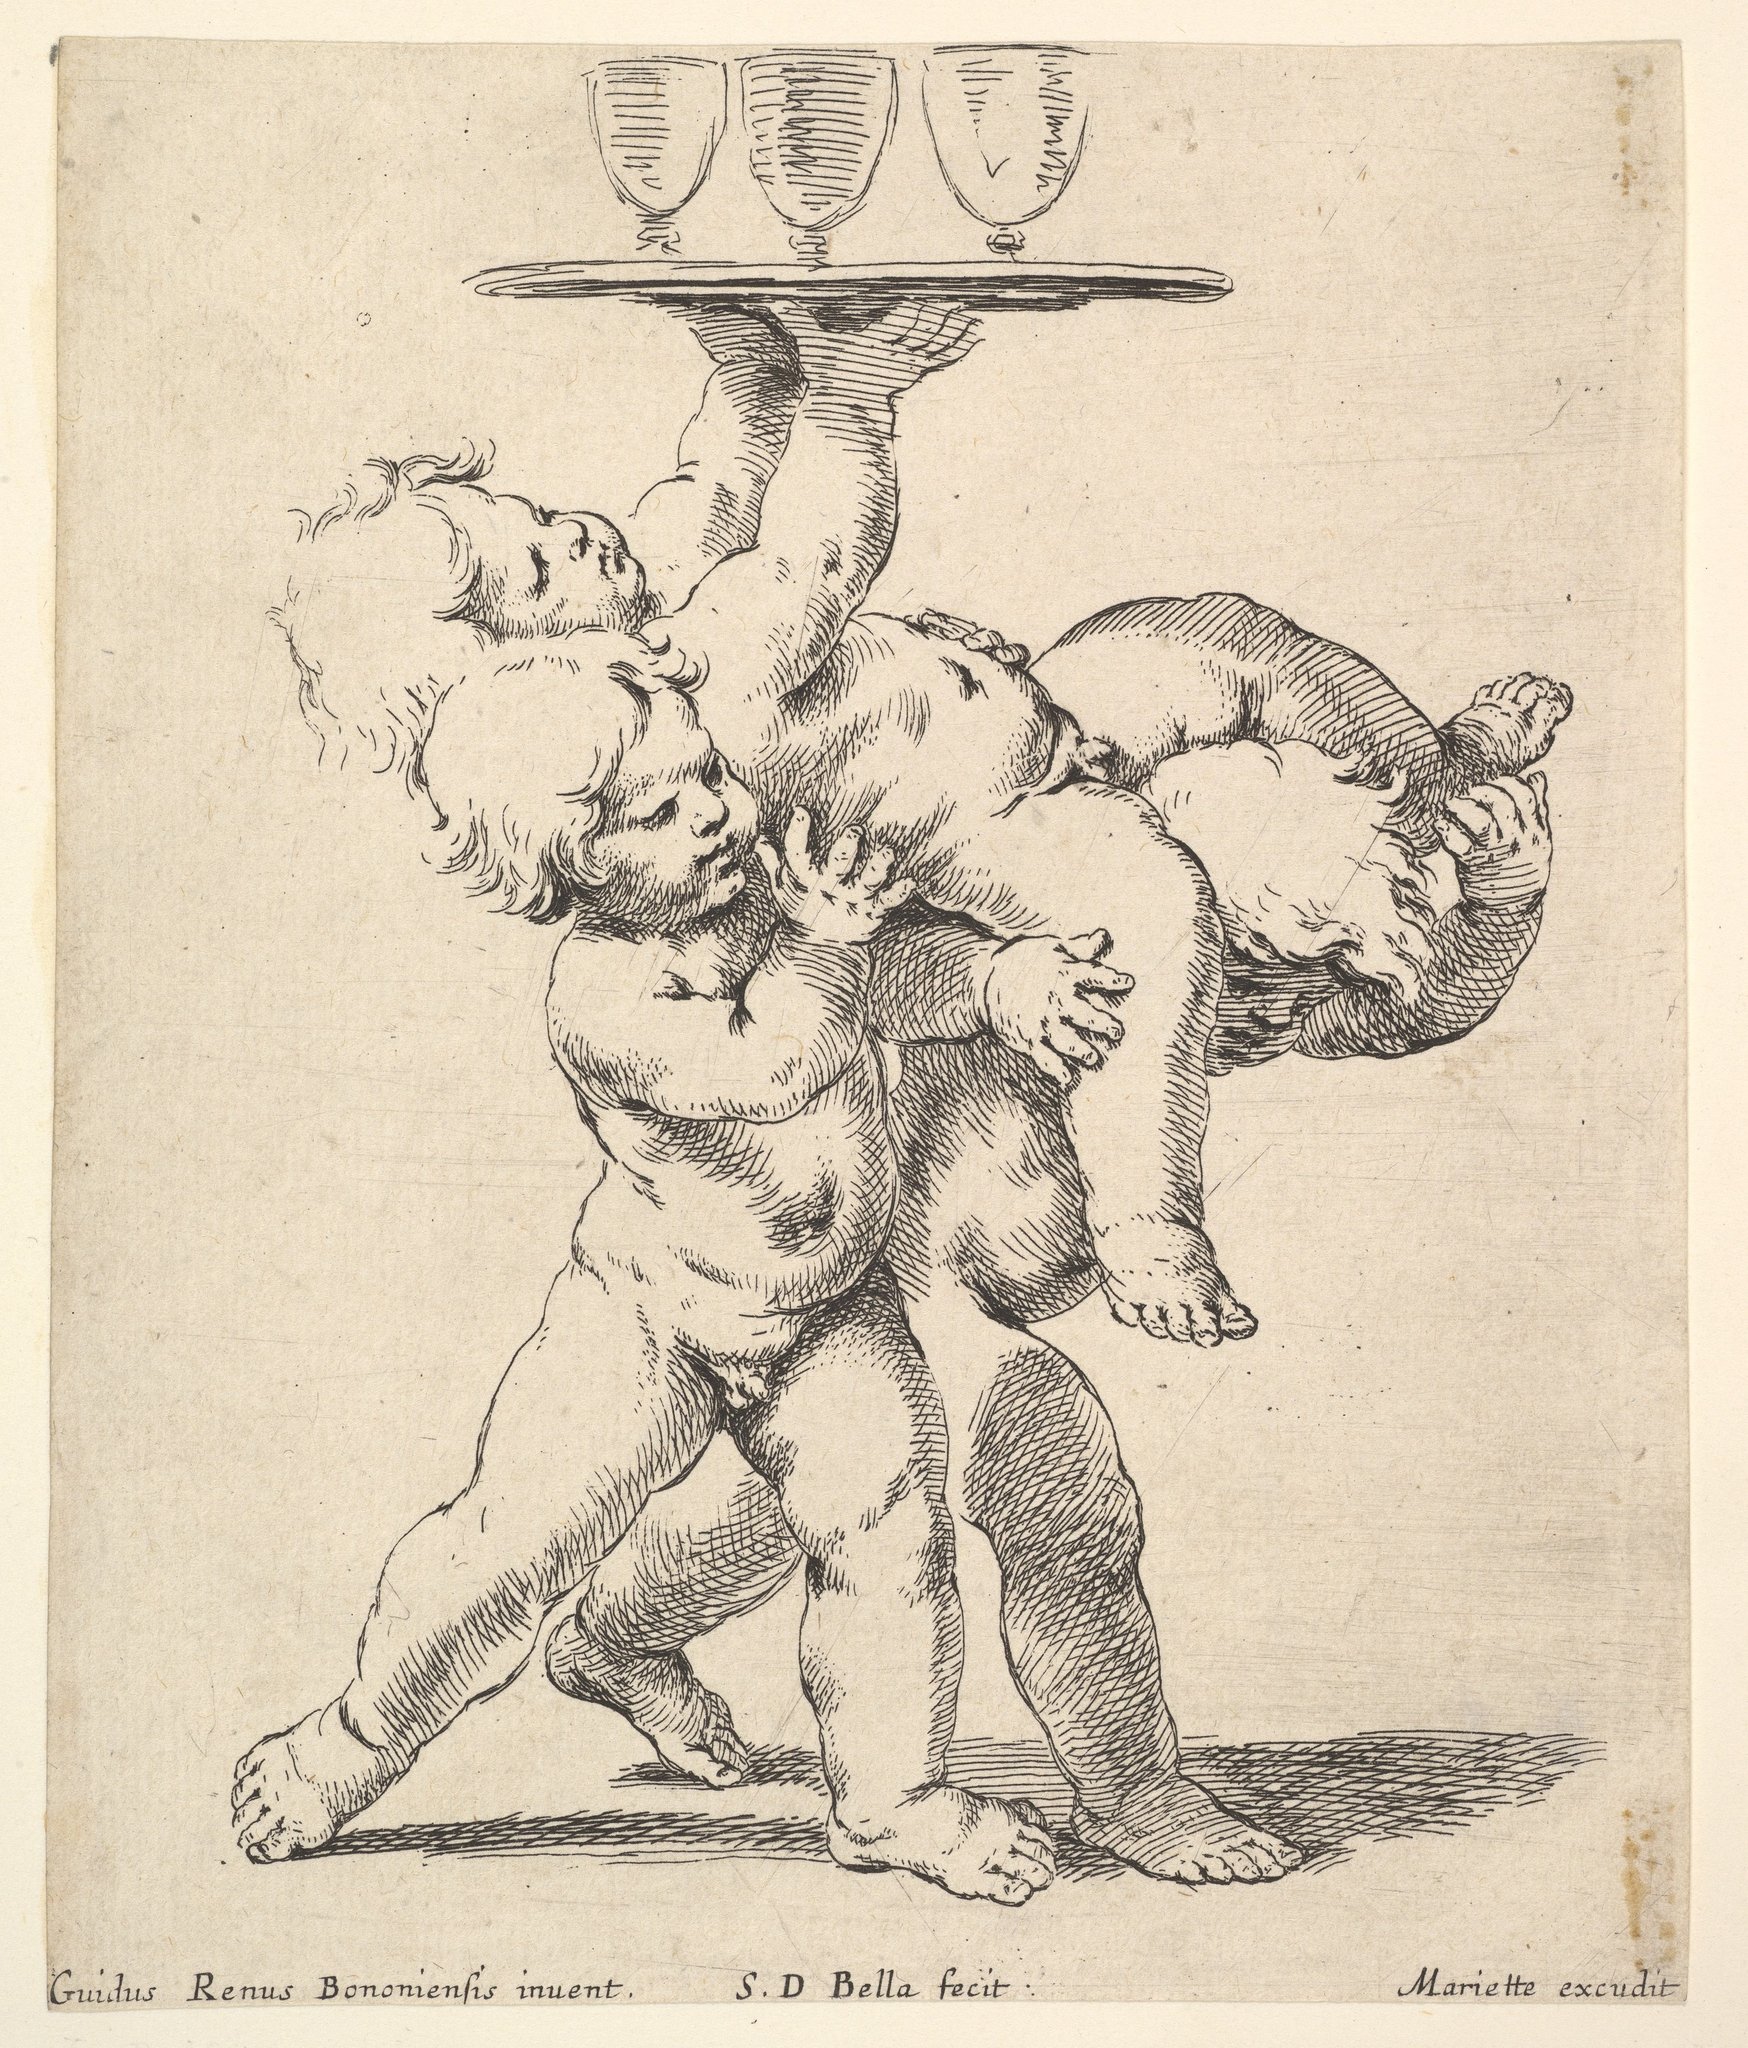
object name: print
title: Three children carrying a tray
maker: stefano della bella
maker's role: artist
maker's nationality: italian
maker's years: 1610-1664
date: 1638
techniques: etching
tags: children,drinking glasses,trays